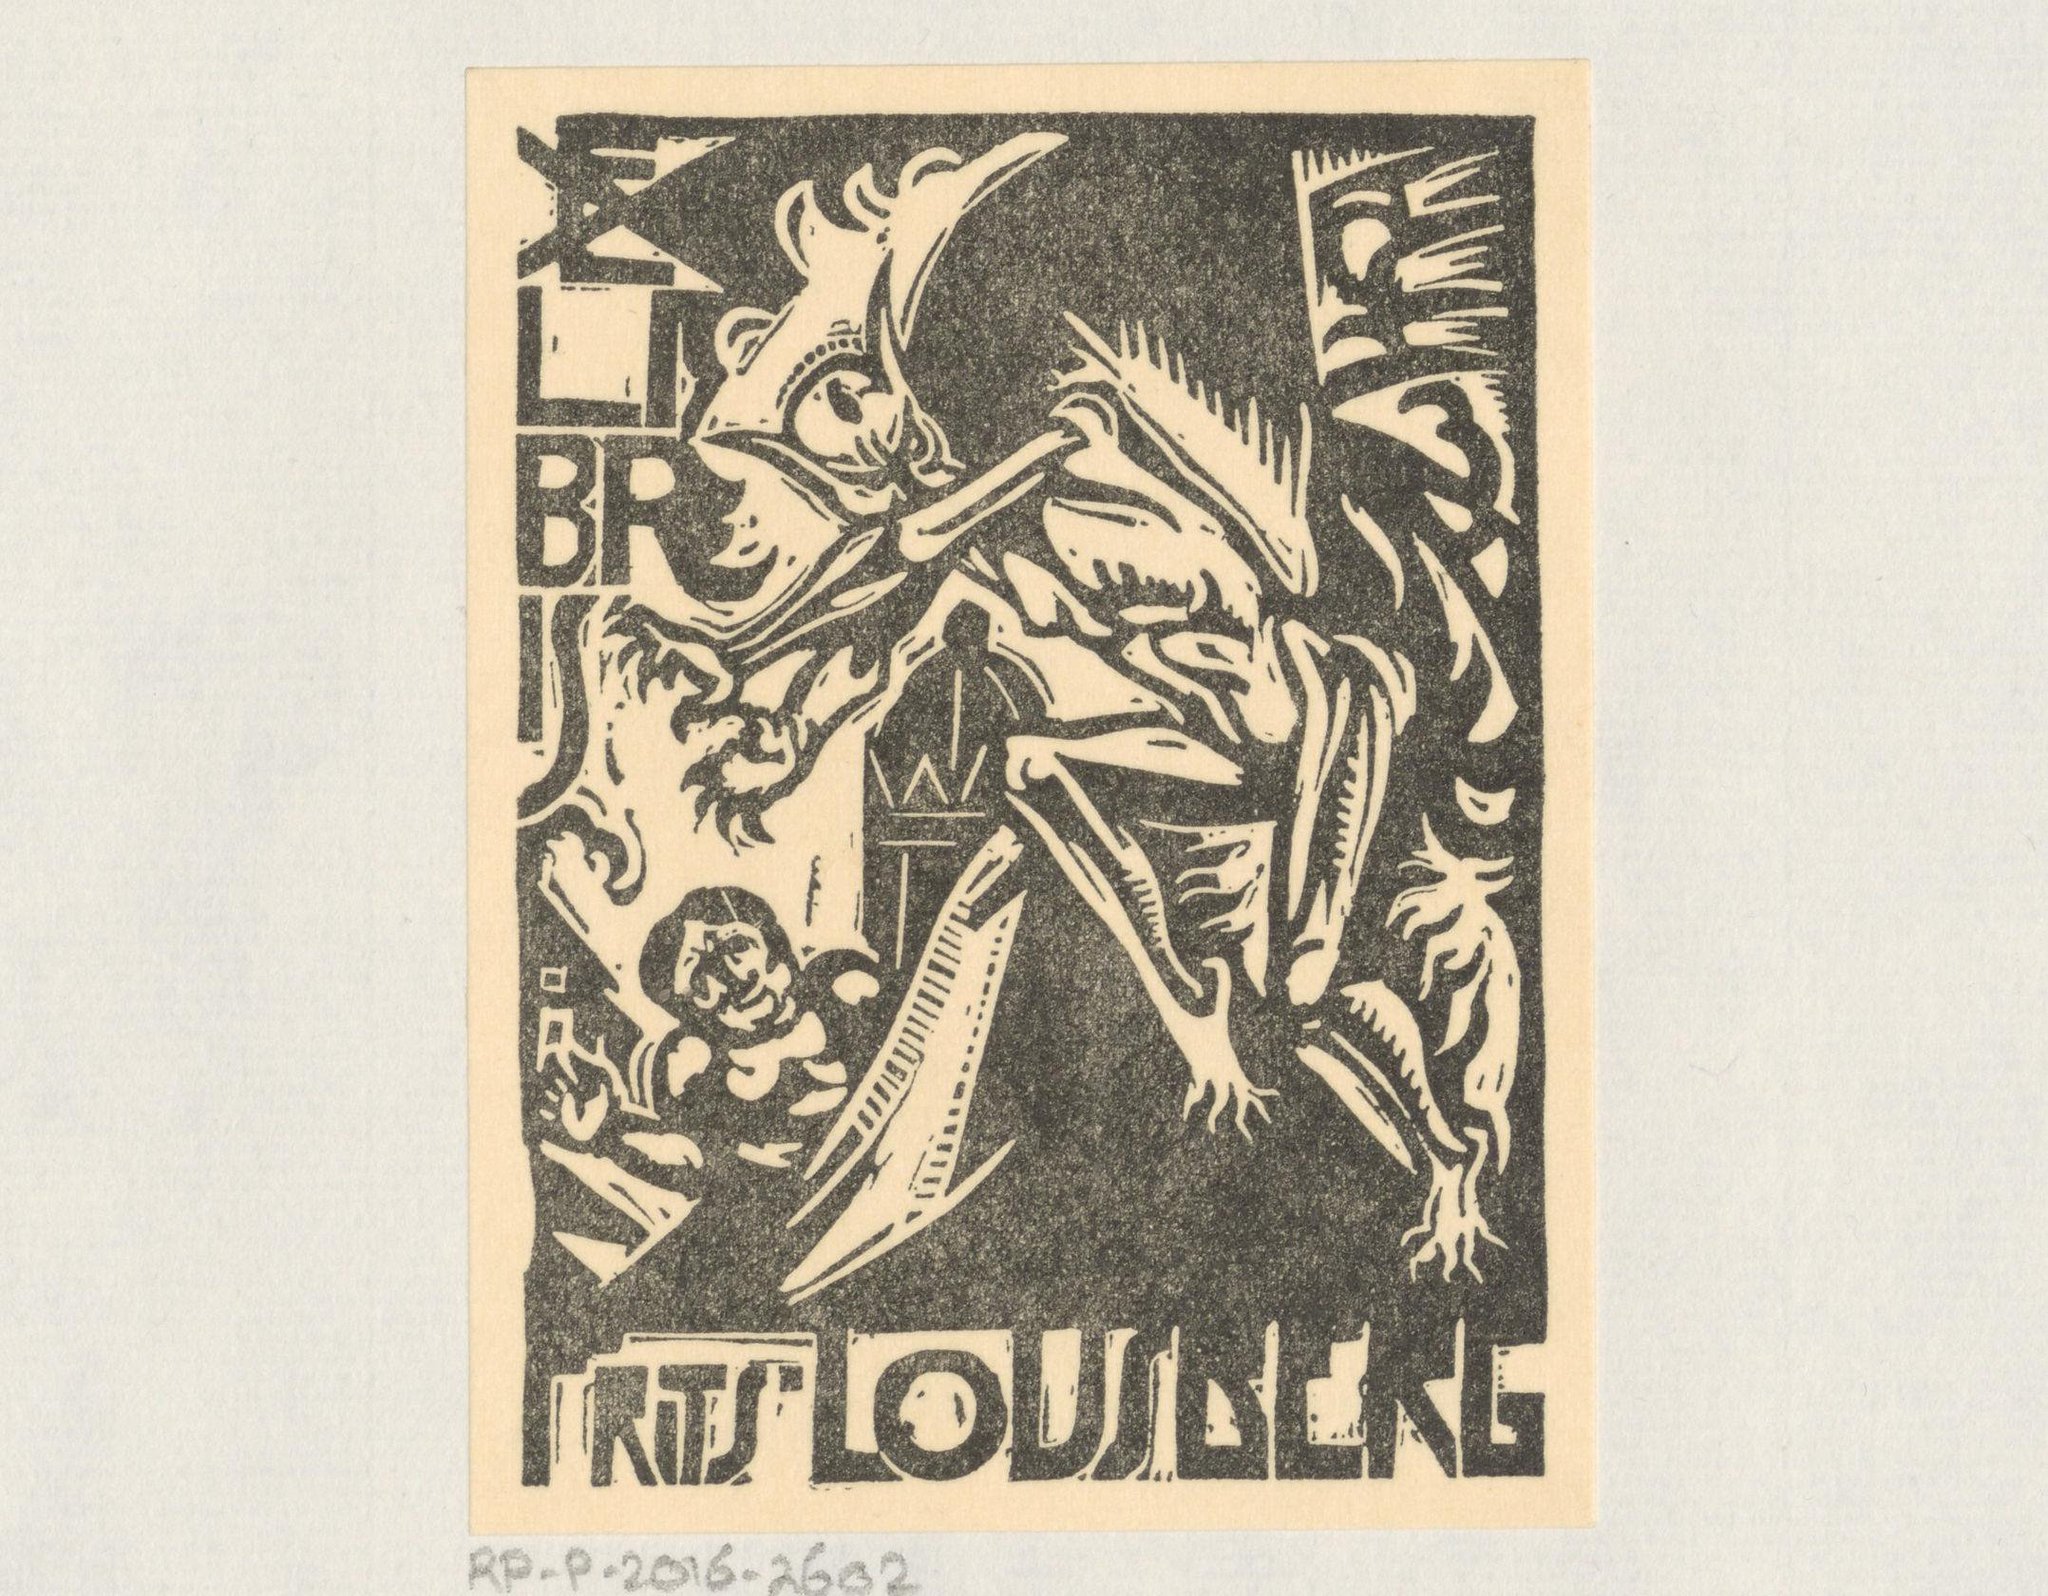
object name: bookplate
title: Ex libris van Frits Lousberg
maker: henri jonas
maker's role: draughtsman, print maker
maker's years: 1878-1944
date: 1925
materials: paper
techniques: woodcut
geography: netherlands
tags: maastricht, devil(s) and demons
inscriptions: inscription: ‘Henri Jonas ±1925’